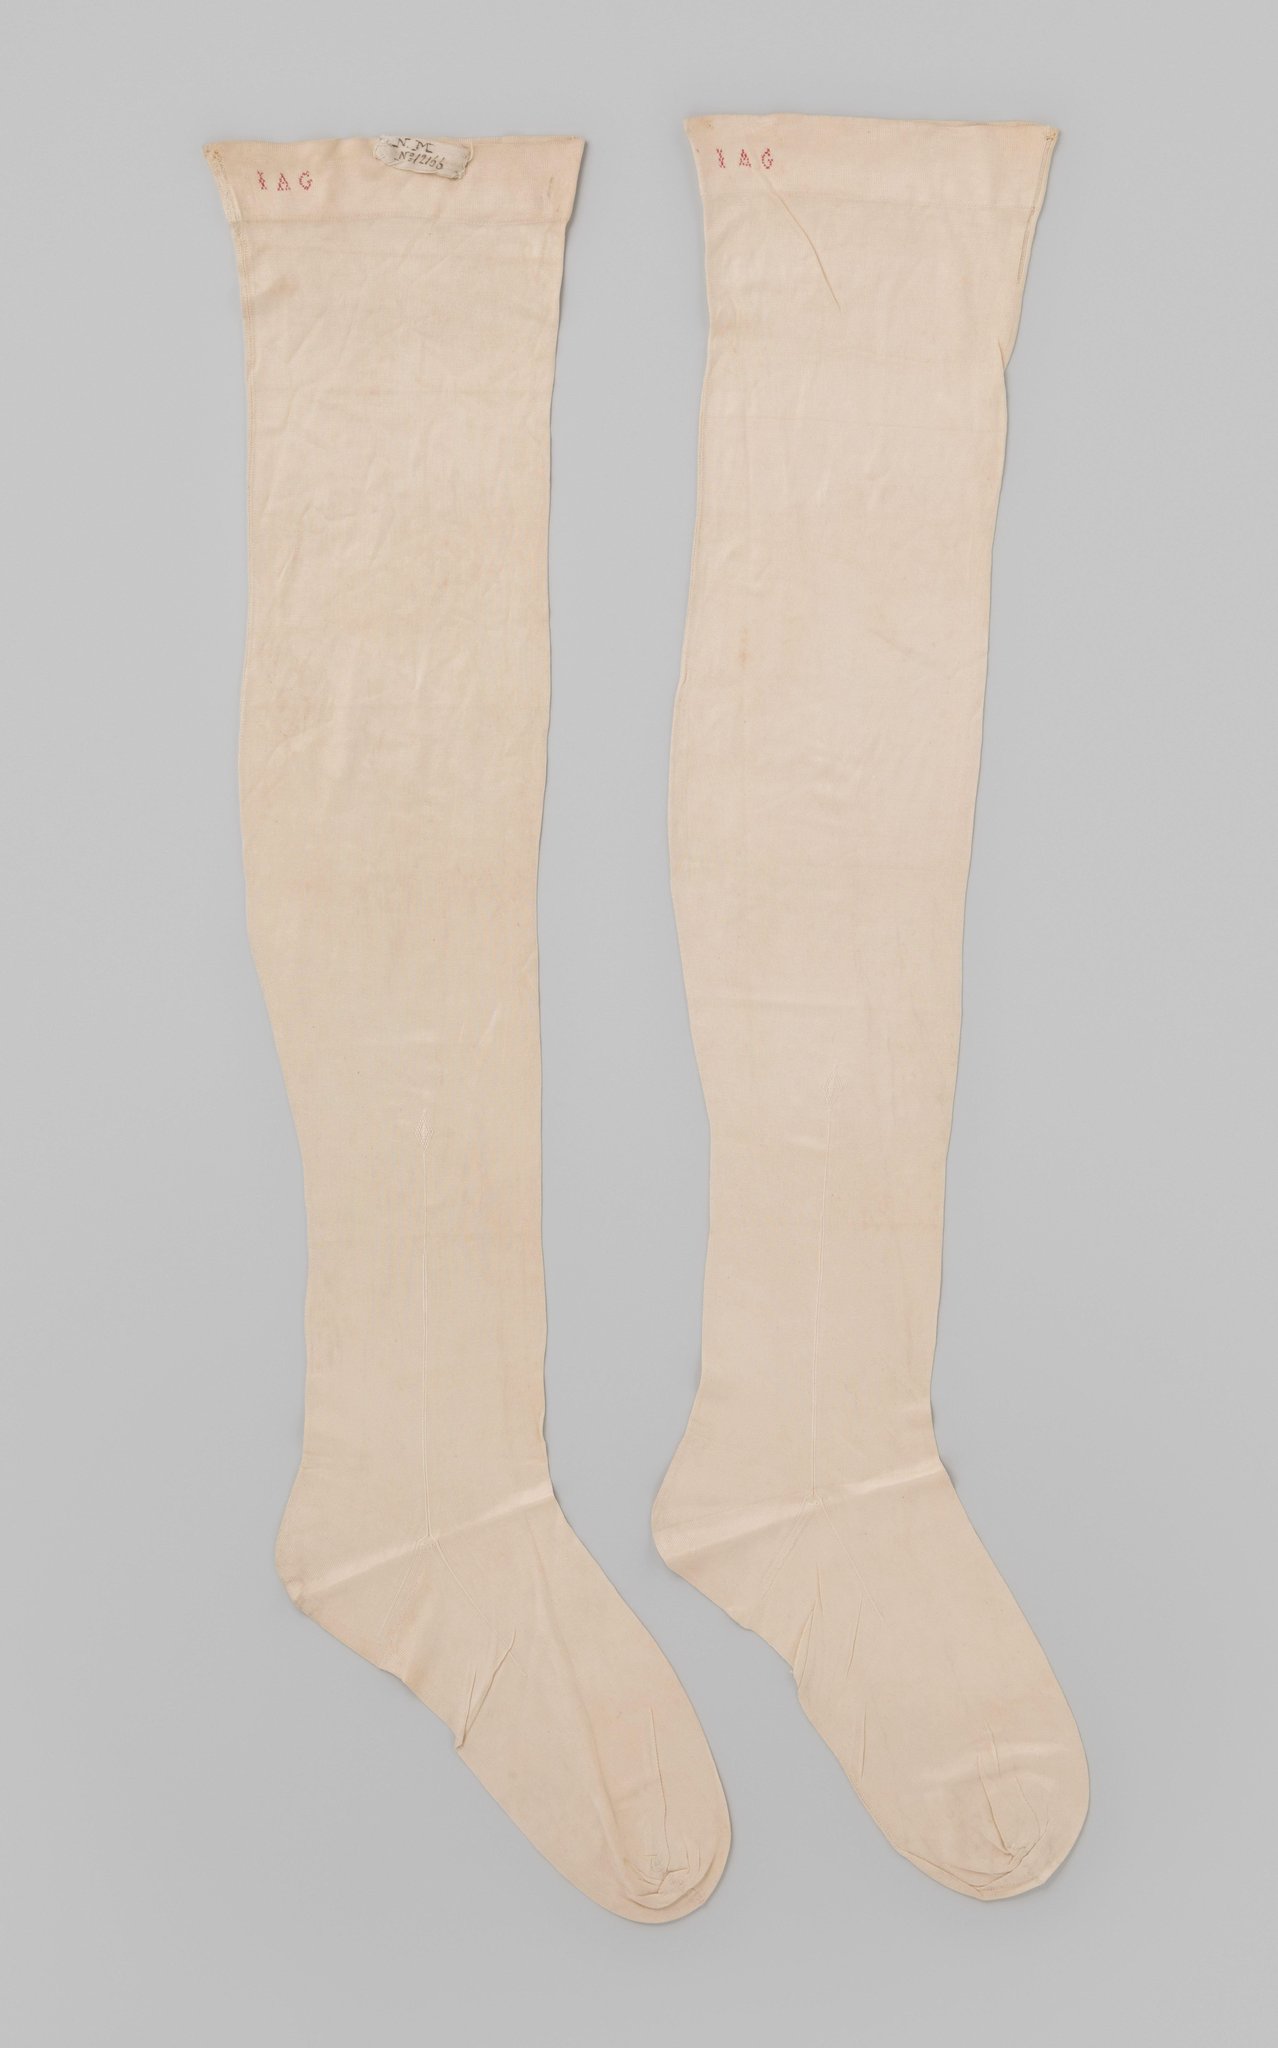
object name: clothing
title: Kous gebreid van effen witte zijde, met langs de klink een geborduurde lijn, uitlopend in een diamantvorm, op de boord in rood in kruissteek 'I.A.G'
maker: Anonymous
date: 1800-1820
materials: silk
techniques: cross stitching, embroidered, knitting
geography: netherlands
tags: vught, overveen, minister, staatsman, secretaris van staat voor financien, minister van financiën, izaak jean alexandre gogel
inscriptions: initials: ‘'I.A.G'’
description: Kous gebreid van effen witte zijde, met langs de klink een geborduurde lijn, uitlopend in een diamantvorm. Naad middenachter. Op de boord in rood in kruissteek 'I.A.G'.